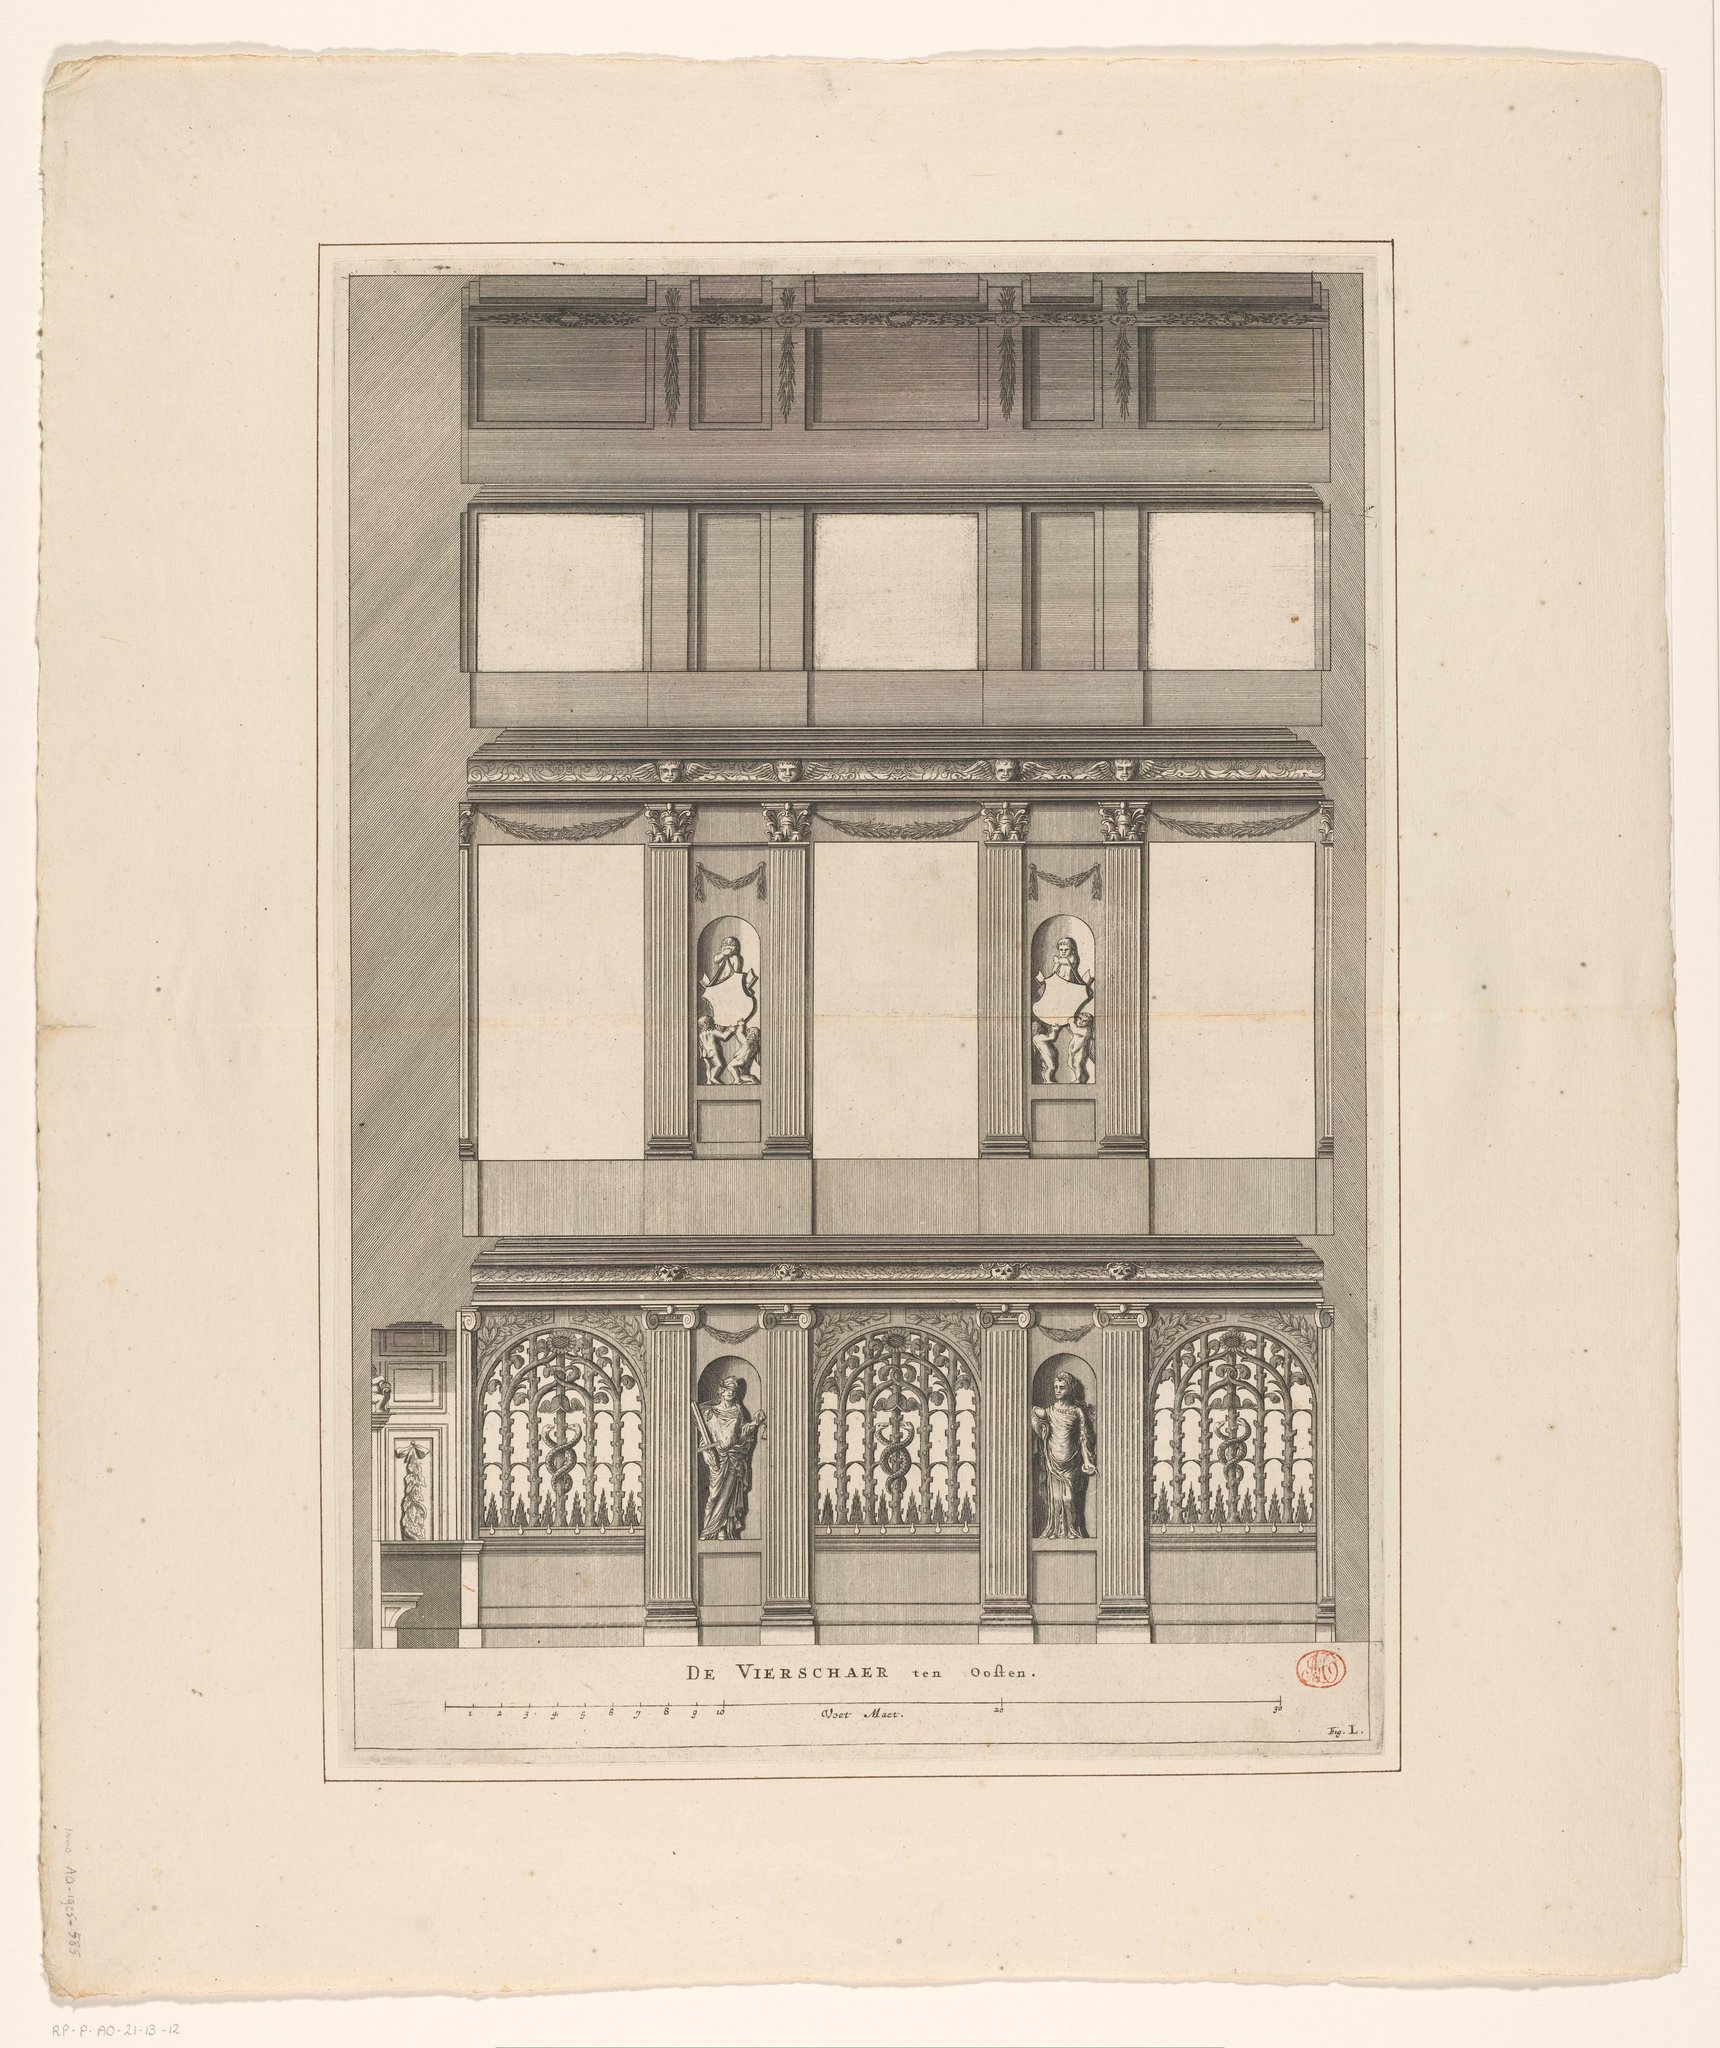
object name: print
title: De Vierschaer ten Oosten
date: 1661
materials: paper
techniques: engraving, etching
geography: amsterdam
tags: interior ~ architectural design or model, justitia (justice) as roman personification, townhall, court-room, prudentia (prudence) as roman personification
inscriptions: collector's mark: Lugt 195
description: De oostelijke muur van de Vierschaar in het Stadhuis op de Dam te Amsterdam. Tussen de twee zuilen links van het midden Justitia, tussen de twee zuilen rechts van het midden Prudentia. Onder de titel een schaalstok: 30 Voet Maet. Rechtsonder gemerkt: Fig. L.